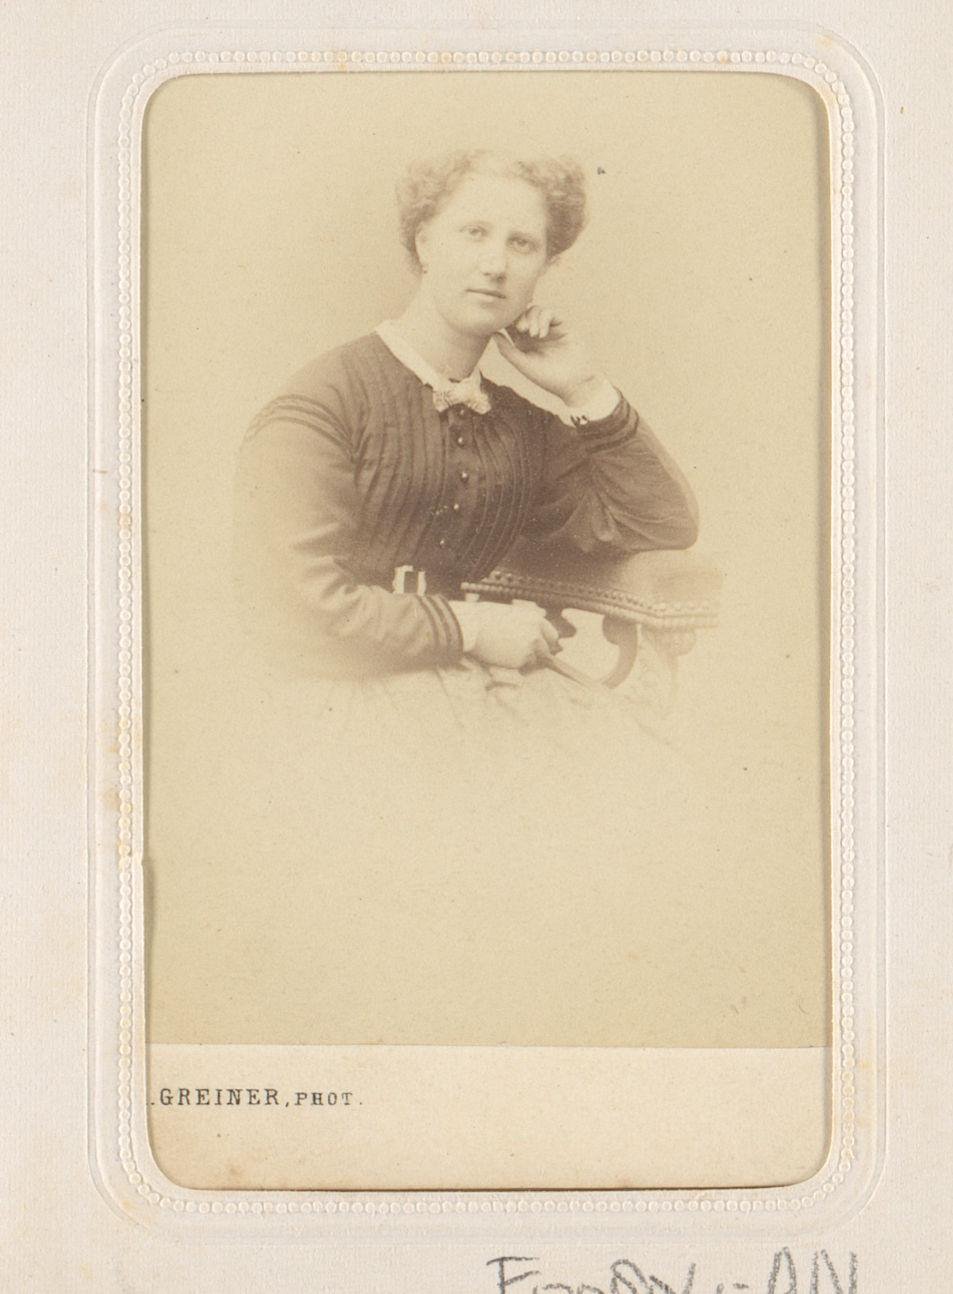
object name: carte de visite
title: Portret van een vrouw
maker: albert greiner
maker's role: fotograaf, fotostudio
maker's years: 1833-1890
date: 1861-1874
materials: cardboard, photographic support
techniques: albumen print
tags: adult woman, historical persons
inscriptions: inscription: ‘A. Greiner/ Photograf/ Nieuwendijk L. 87/ Amsterdam’